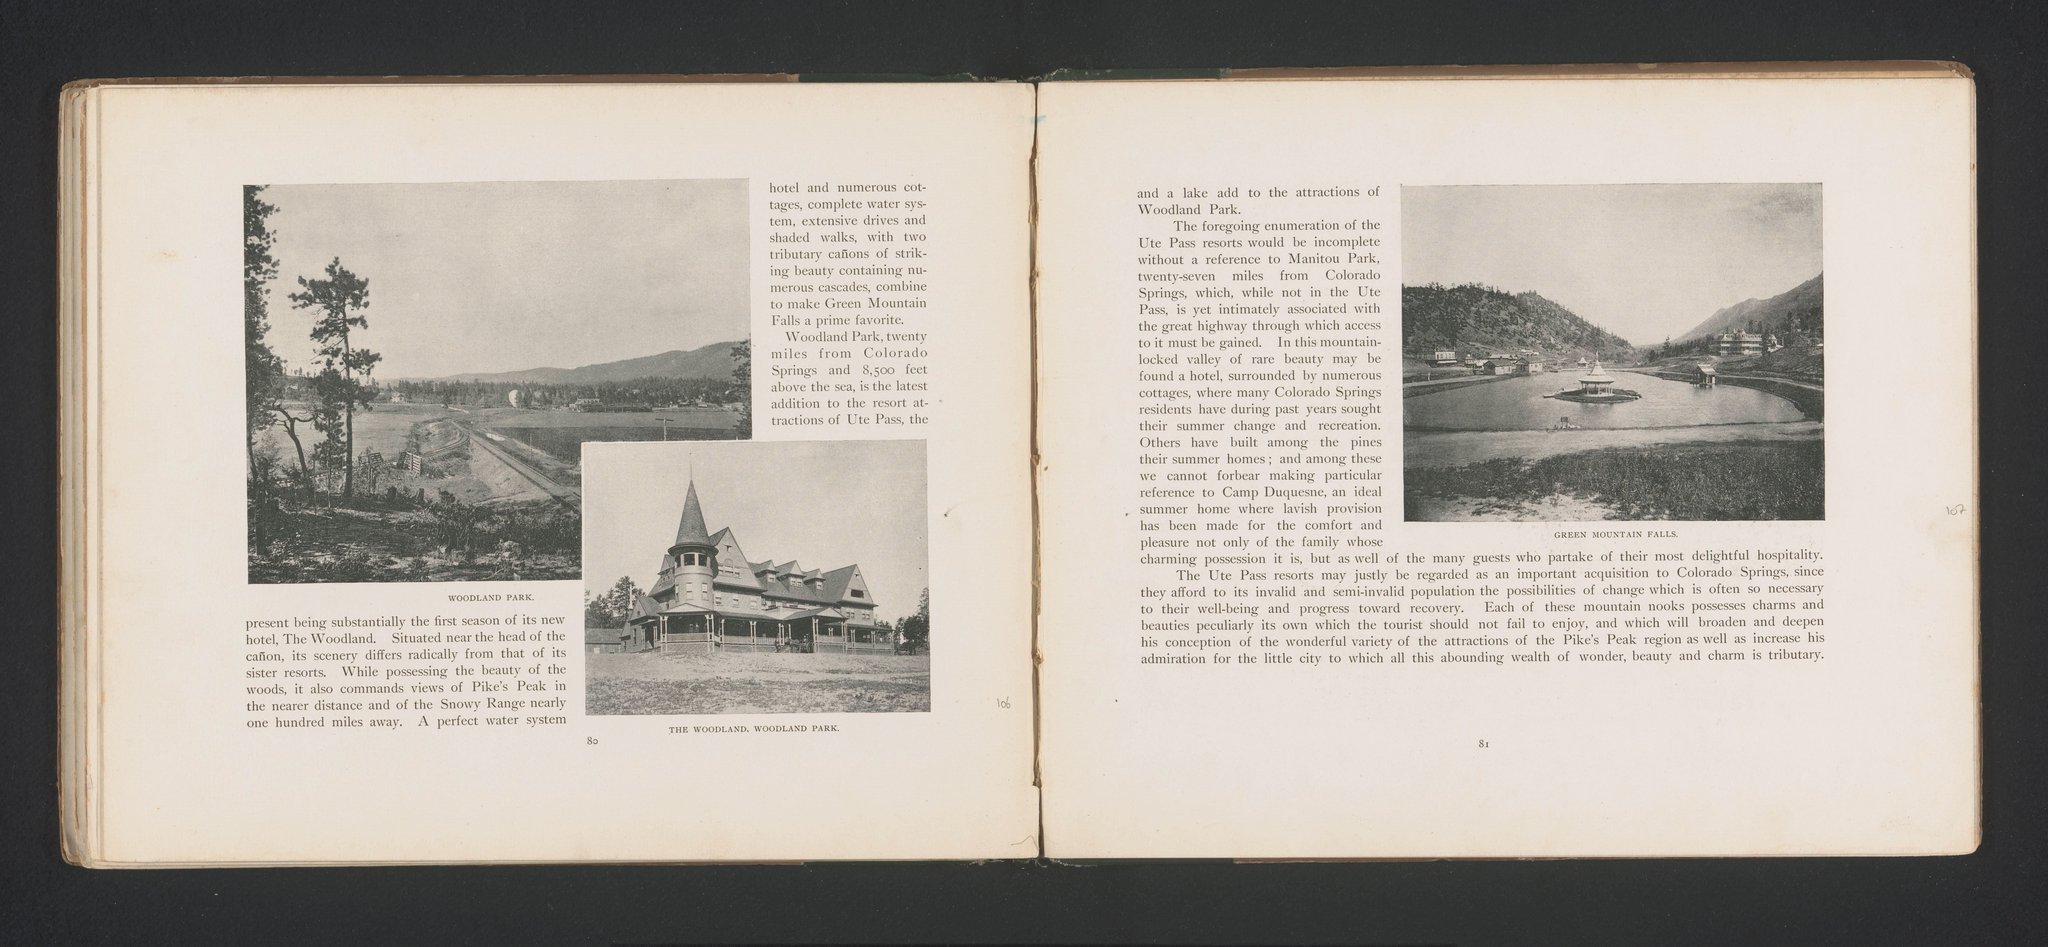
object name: page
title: Gezicht op Green Mountain Falls te Colorado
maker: Anonymous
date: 1888-1893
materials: paper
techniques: autotype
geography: new york city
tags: dale, valley, city-view in general; 'veduta'